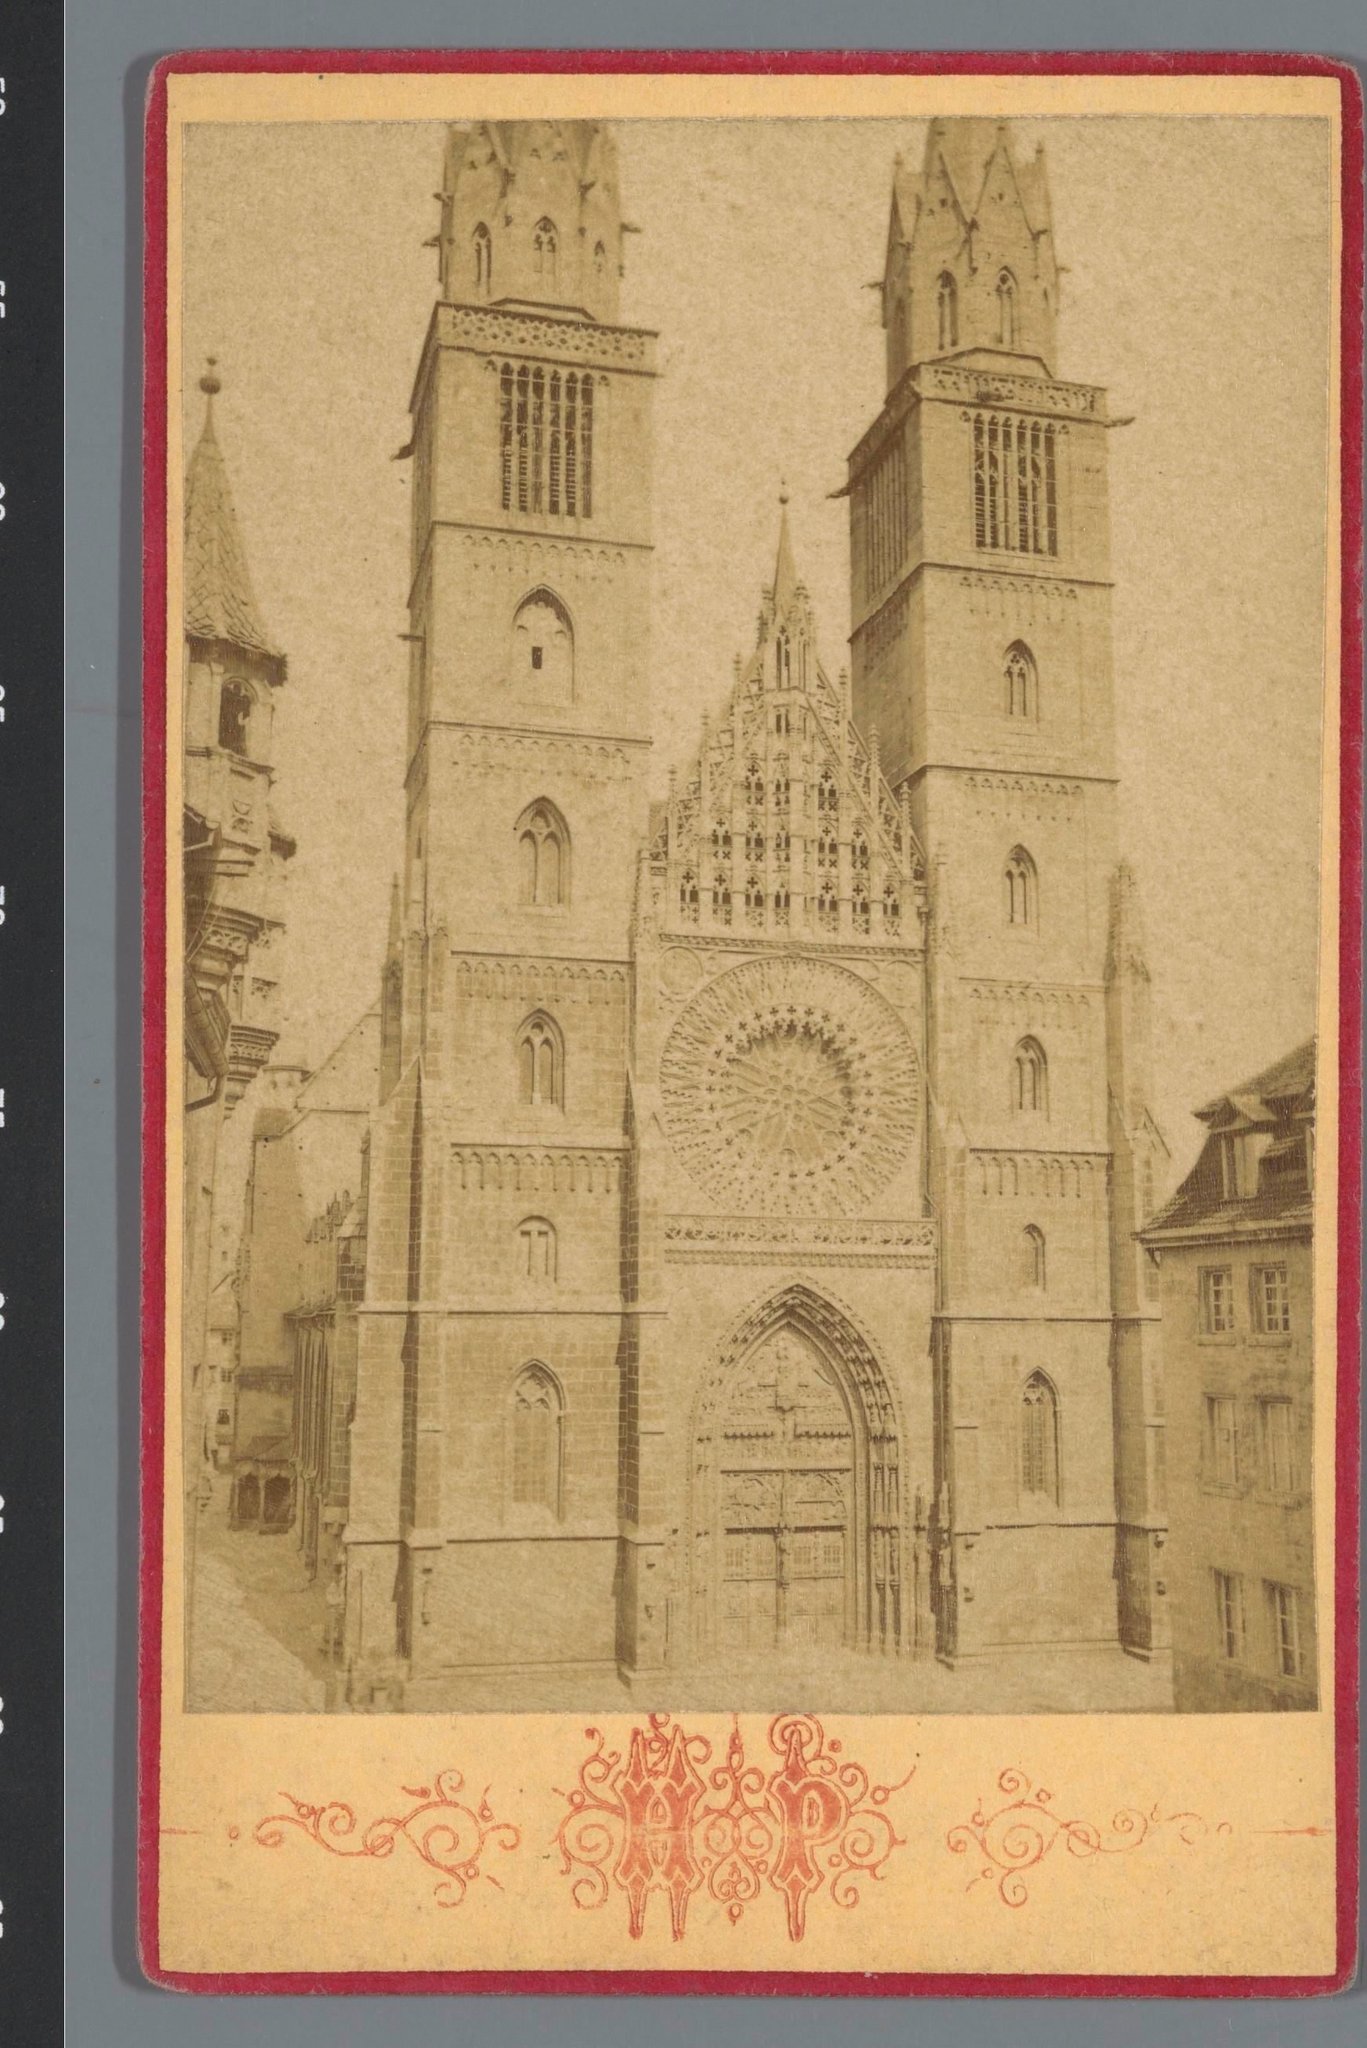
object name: carte de visite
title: Lorenzkerk te Neurenberg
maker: hp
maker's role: fotograaf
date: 1873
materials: cardboard, paper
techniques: albumen print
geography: nuremberg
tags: church (exterior)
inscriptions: monogram: ‘HP’